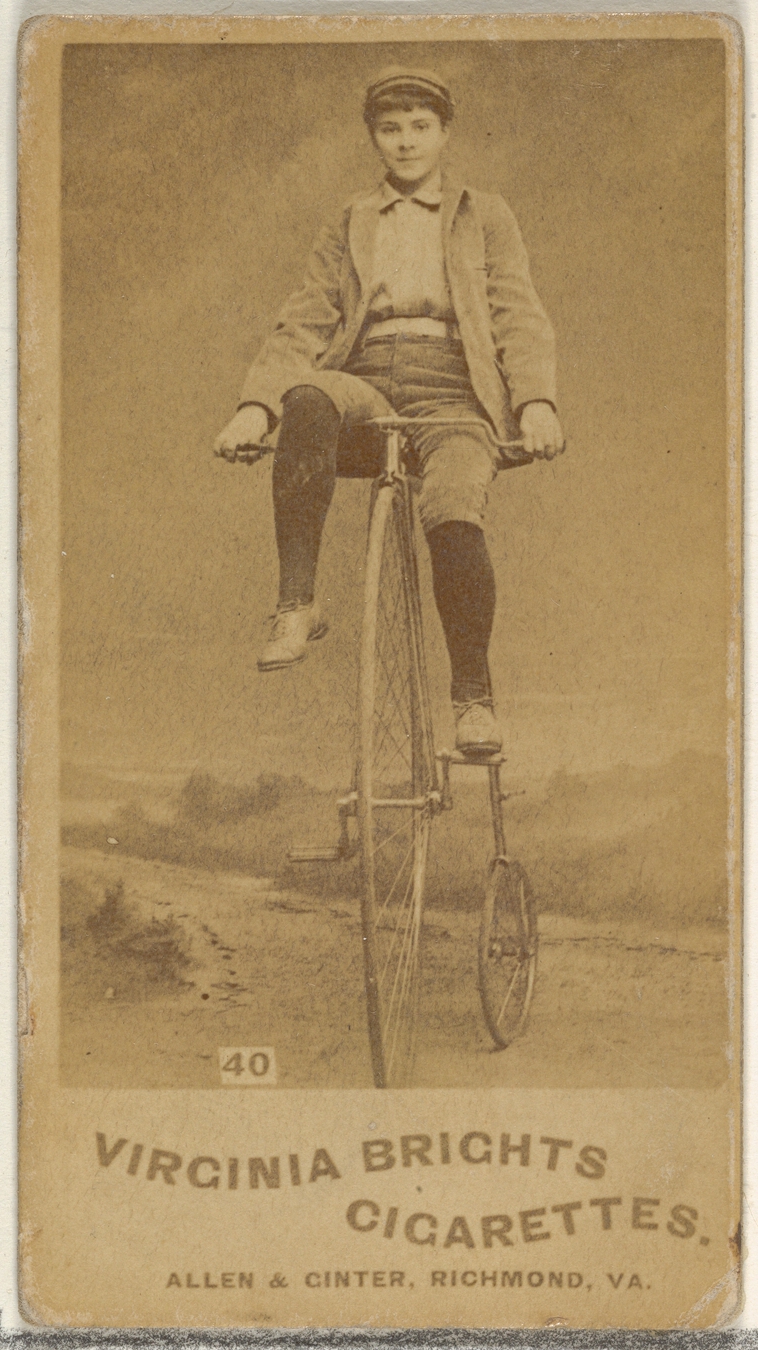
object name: photograph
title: Card 40, from the Girl Cyclists series (N49) for Virginia Brights Cigarettes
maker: allen & ginter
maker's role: publisher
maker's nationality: american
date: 1887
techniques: albumen silver print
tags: girls,portraits,bicycles